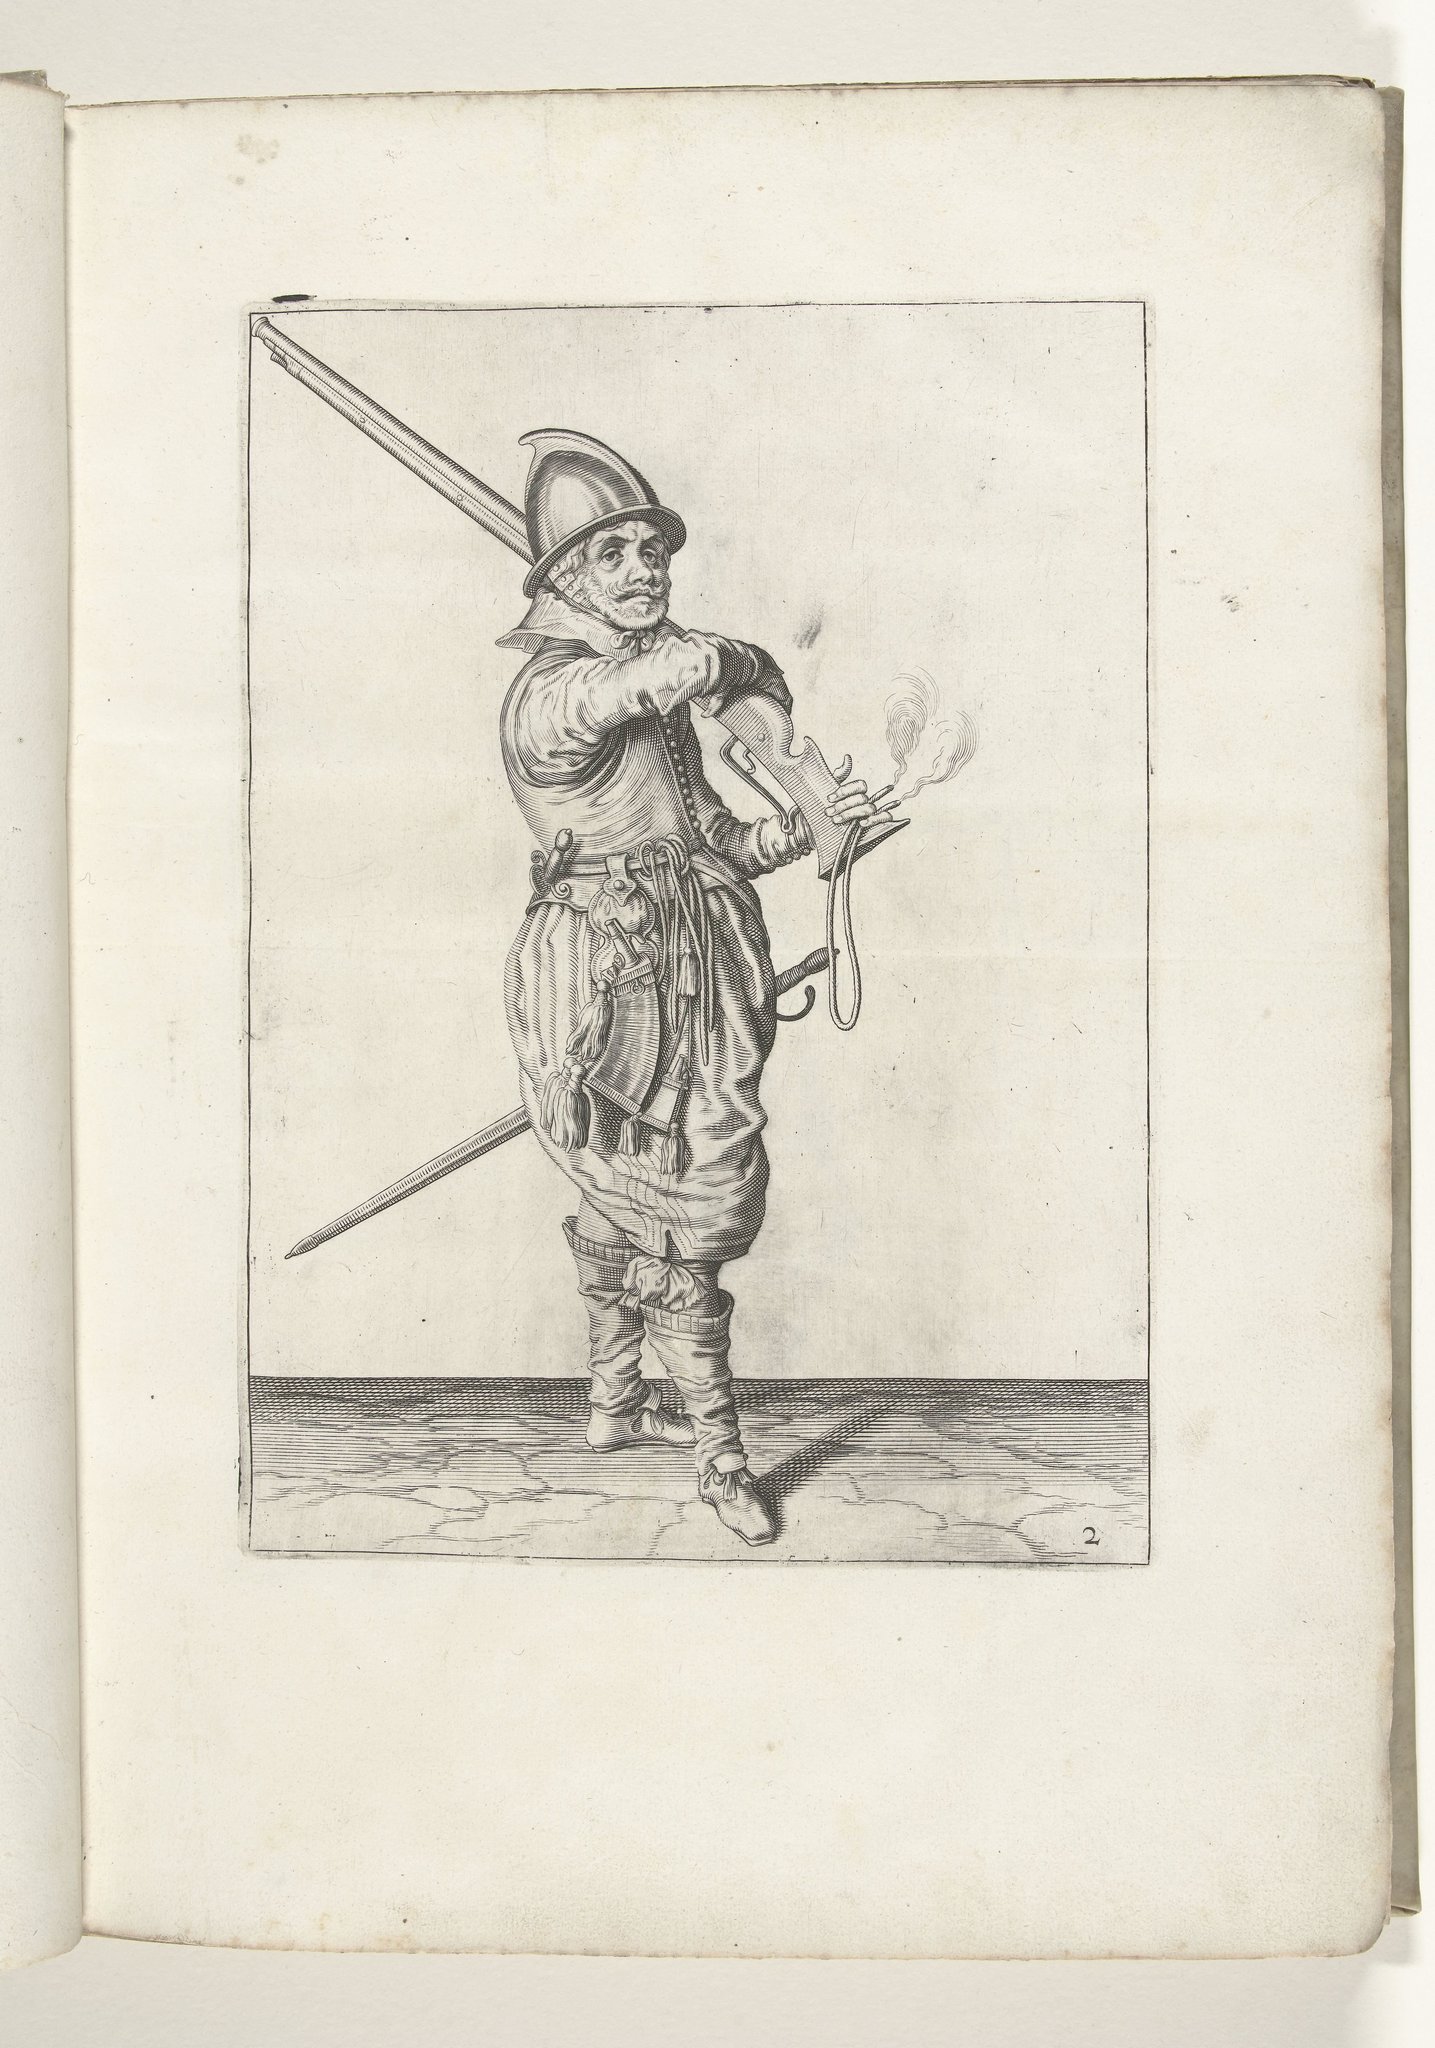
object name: print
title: Soldaat die zijn roer van zijn schouder neemt (nr. 2), ca. 1600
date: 1597-1607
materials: paper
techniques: engraving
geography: northern netherlands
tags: the hague, maurice (prince of orange), handling of weapons ~ military training, weapons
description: Een soldaat, ten voeten uit, naar rechts, die een roer (een bepaald type vuurwapen) van zijn linkerschouder neemt met zijn rechterhand (nr. 2), ca. 1600. In zijn linkerhand behalve de kolf van het roer ook een brandende lont. Plaat 2 in de instructies voor het hanteren van de roer: Corte onderwysinghe op de figuerliicke afbeeldinghe, belanghende t'rechte ghebruyck des Roers. Onderdeel van de illustraties in: J. de Gheyn, Wapenhandelinghe van Roers Musquetten ende spiessen, 's-Gravenhage, 1607. Krijgswezen rond 1600.